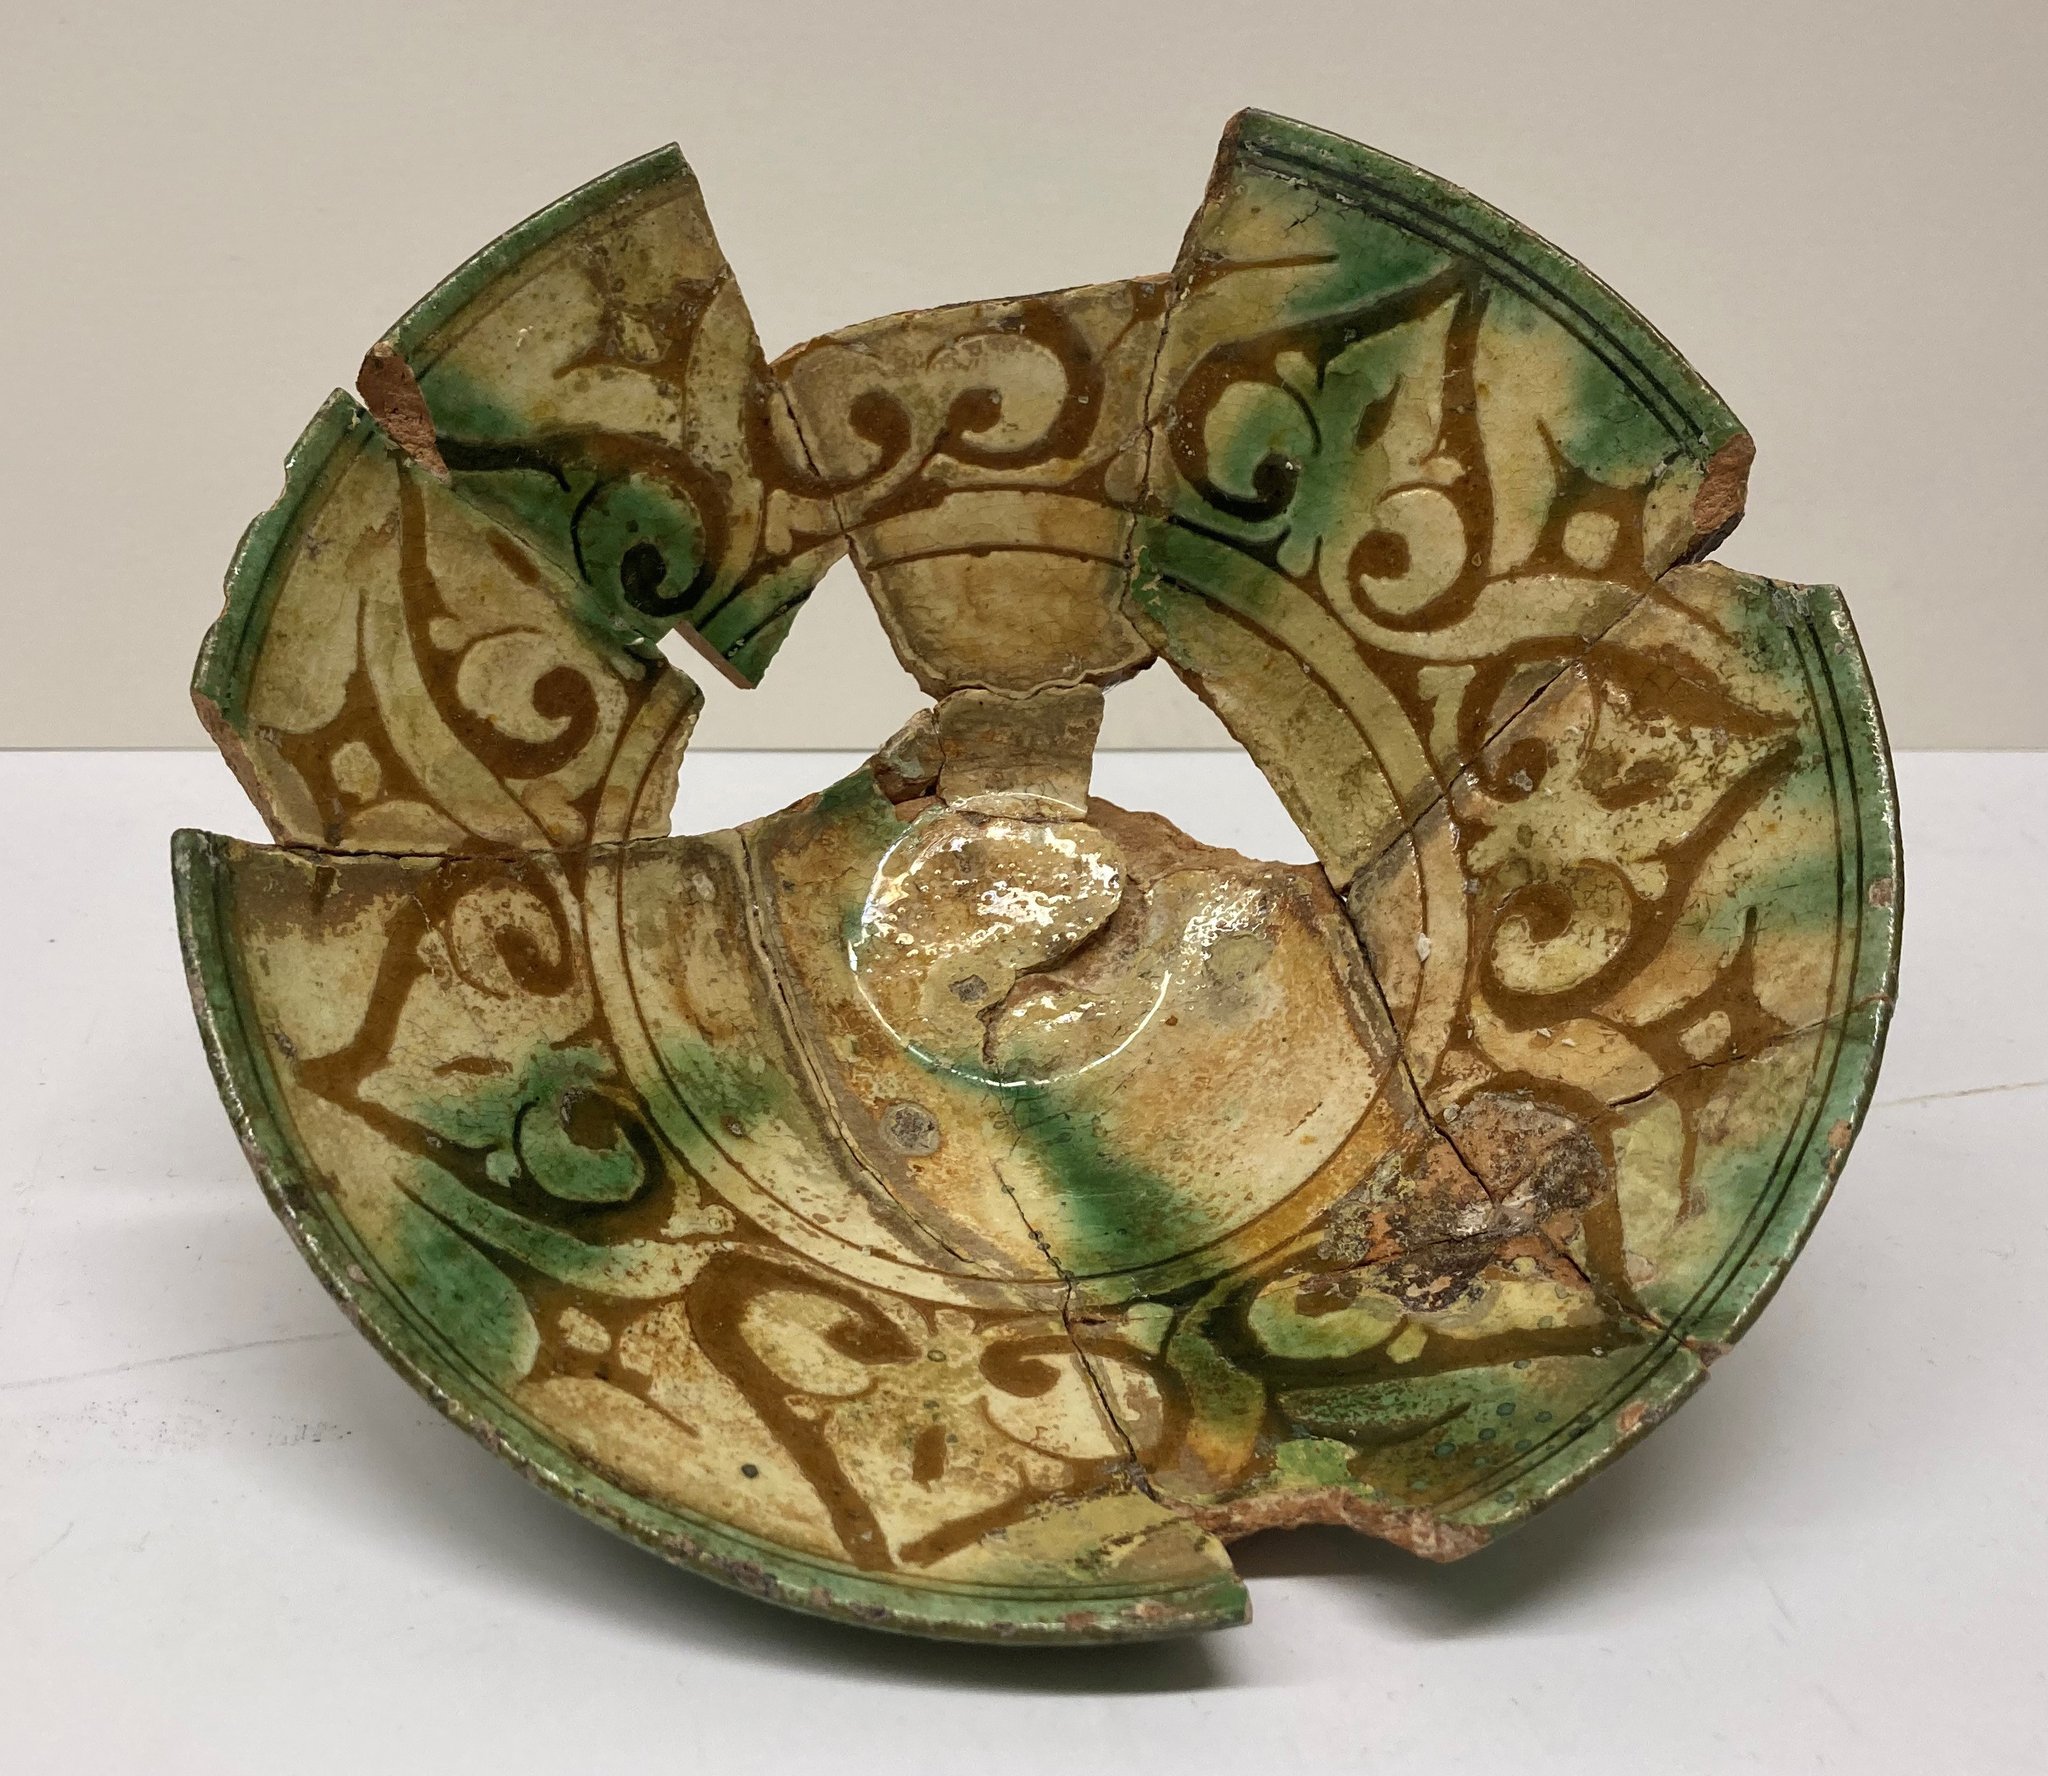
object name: bowl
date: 1001-1200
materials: stonepaste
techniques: glazing, painting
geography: iran